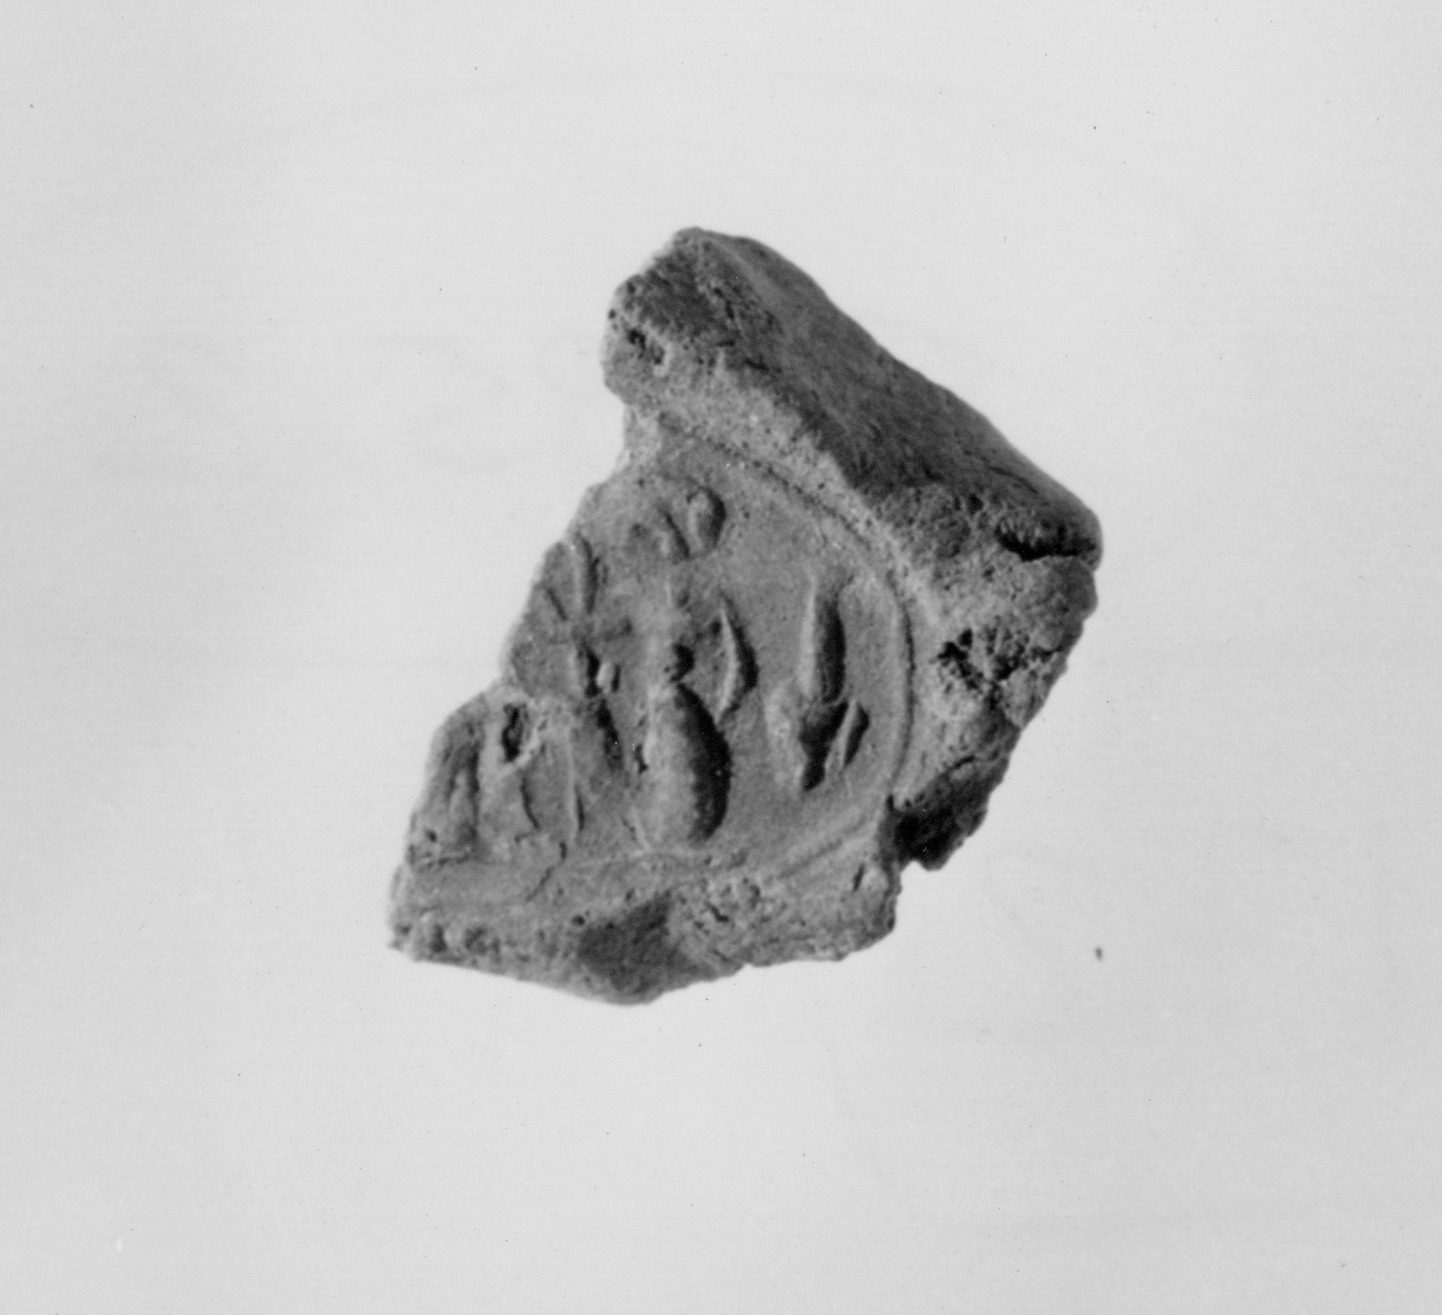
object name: sealing, nebmaatre, amenhotep iii, horus, re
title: Document Sealing With the Throne Name of Amenhotep III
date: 1390-1352 BCE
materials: mud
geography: egypt